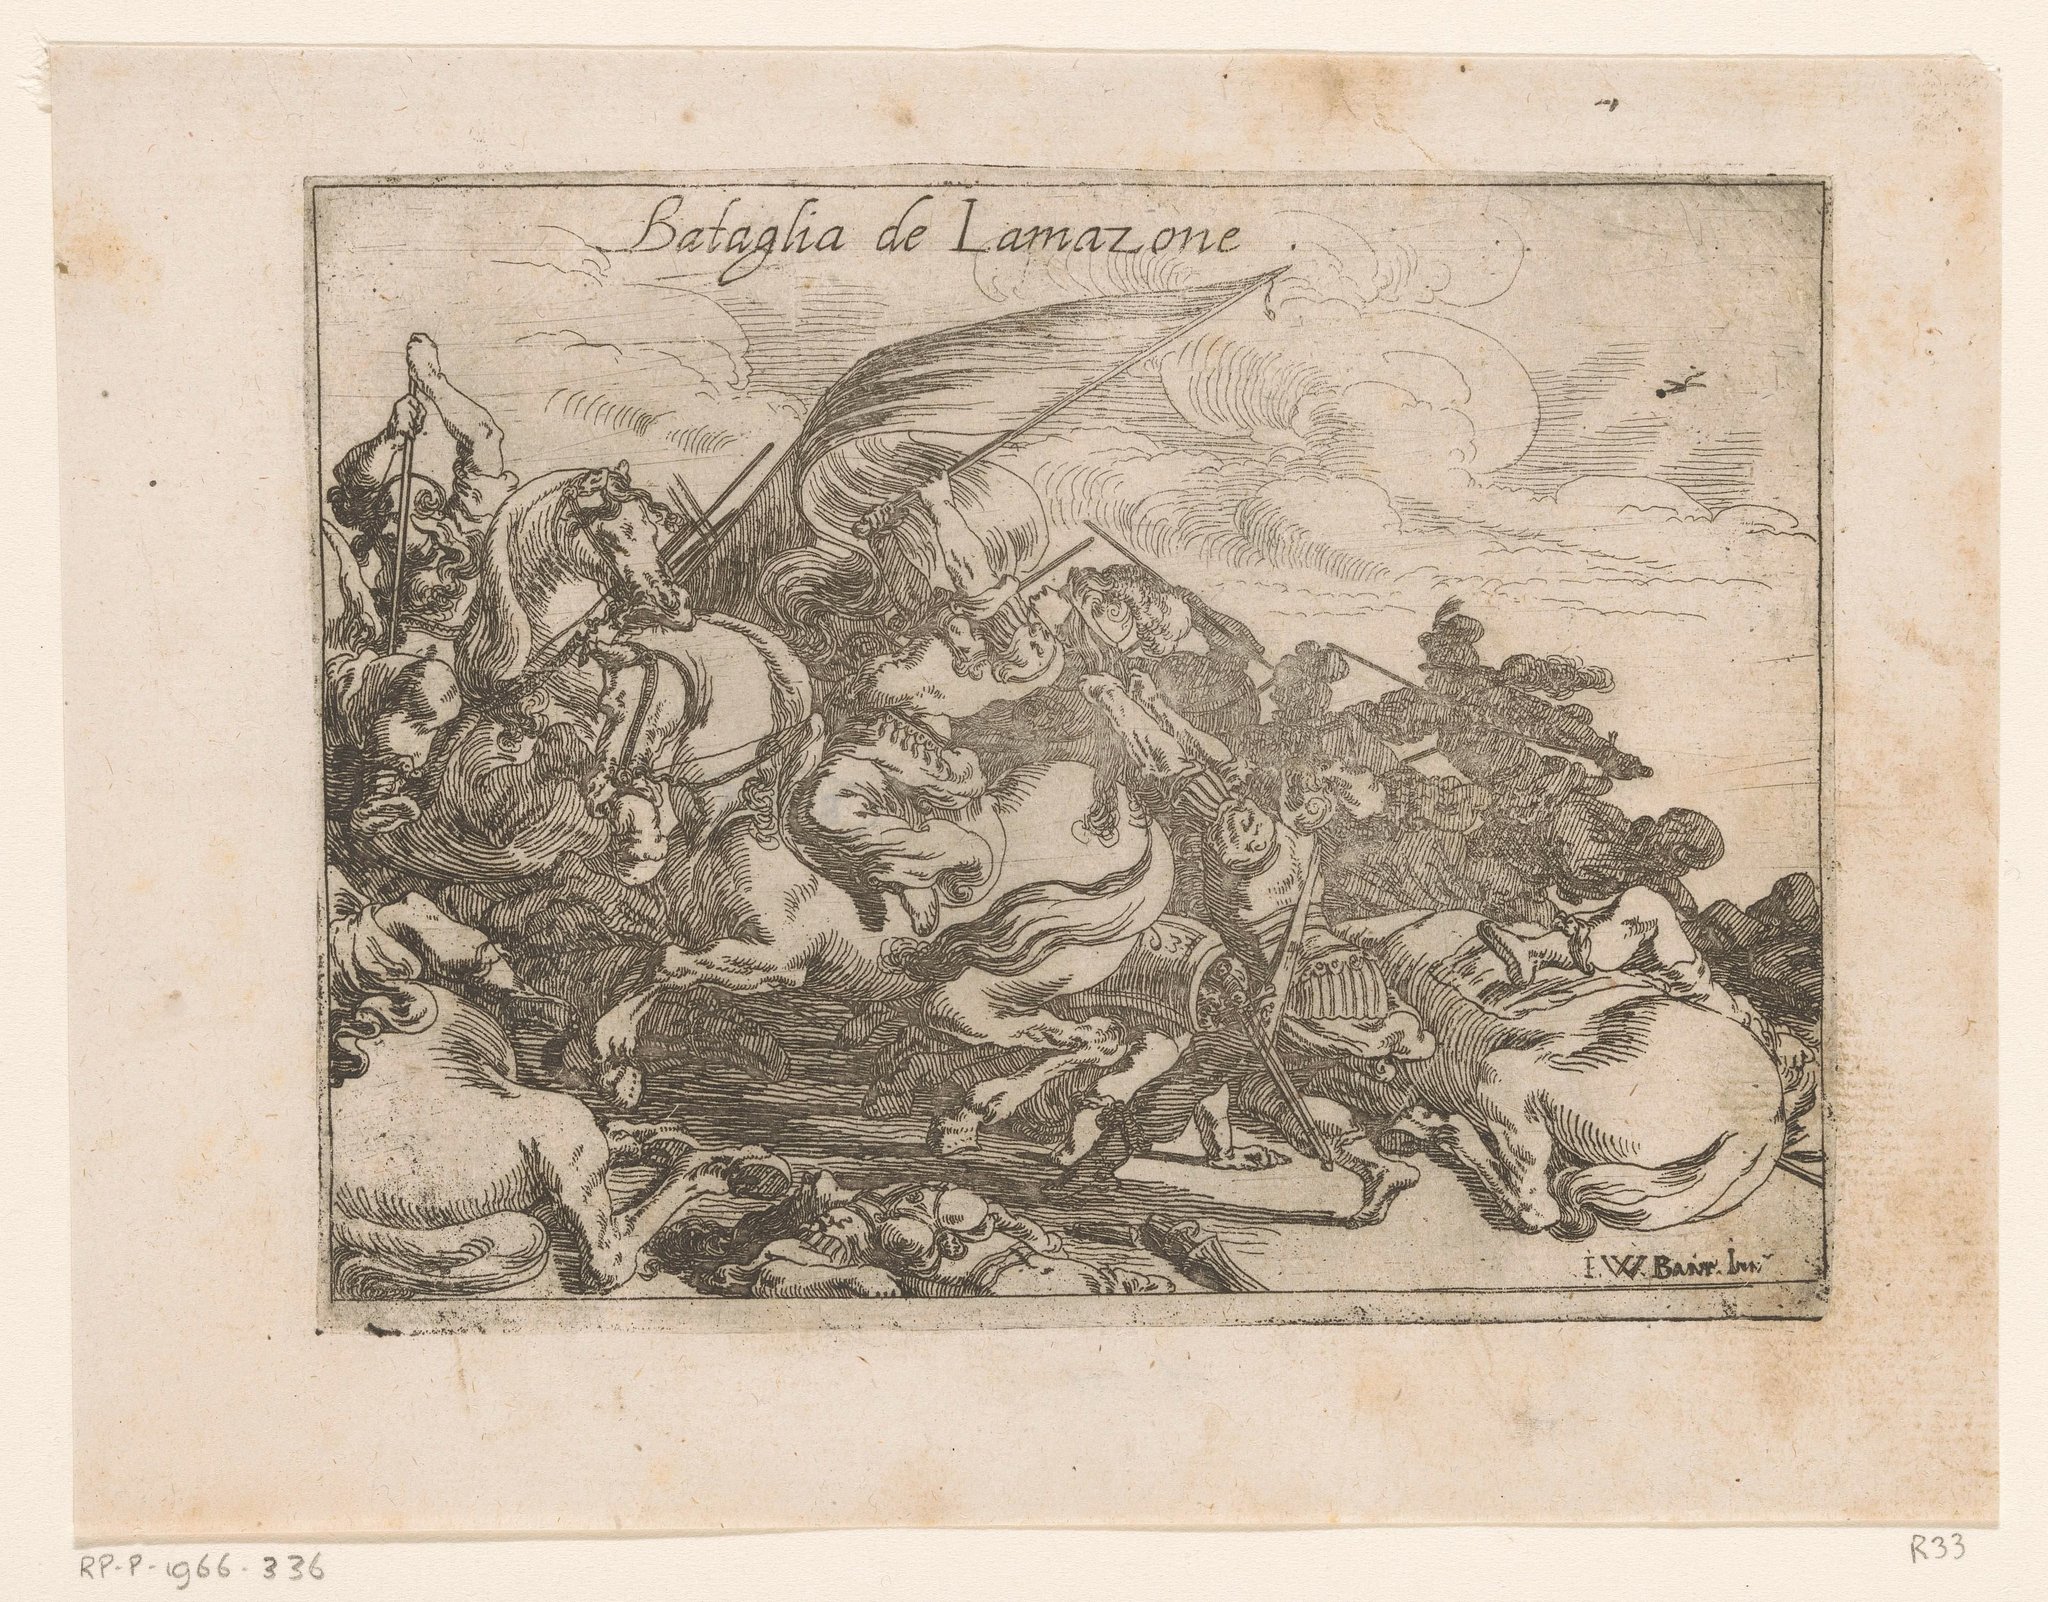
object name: print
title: Bataglia de Lamazone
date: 1633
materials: paper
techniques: etching, intaglio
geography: italy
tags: battle of amazons; amazonomachy, battle (+ cavalry, horsemen)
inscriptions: collector's mark: Lugt 2228, collector's mark: Lugt 5k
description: Tiende prent uit de serie 'Veldslagen door verschillende volkeren', bestaand uit een titelprent en dertien prenten.